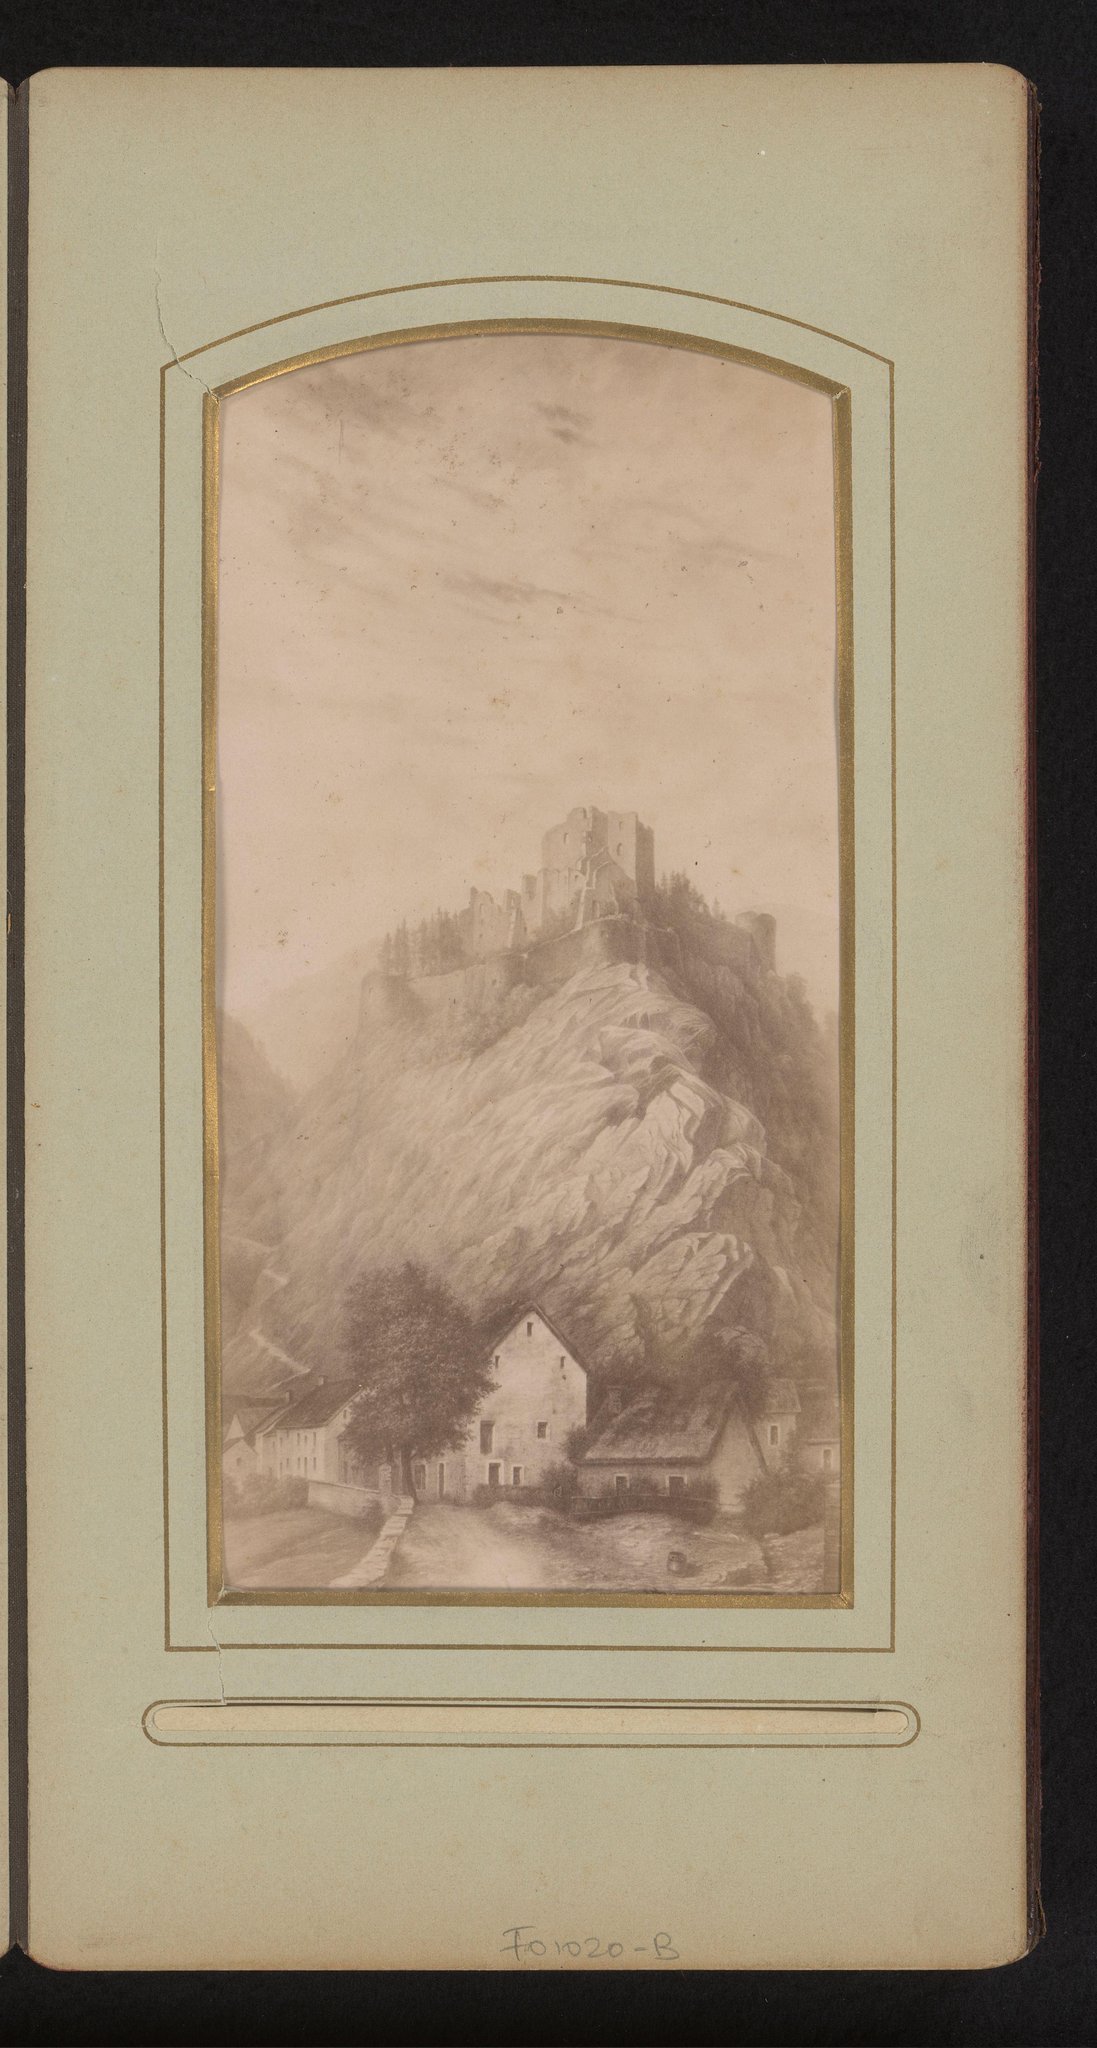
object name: album leaf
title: Fotoreproductie van een prent van de ruïne van een kasteel op een berg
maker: nicolas maroldt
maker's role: fotograaf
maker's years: 1843-1906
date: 1860-1889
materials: photographic support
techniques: albumen print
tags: trees, the graphic arts, ruin of a dwelling, house, castle, etc., mountains